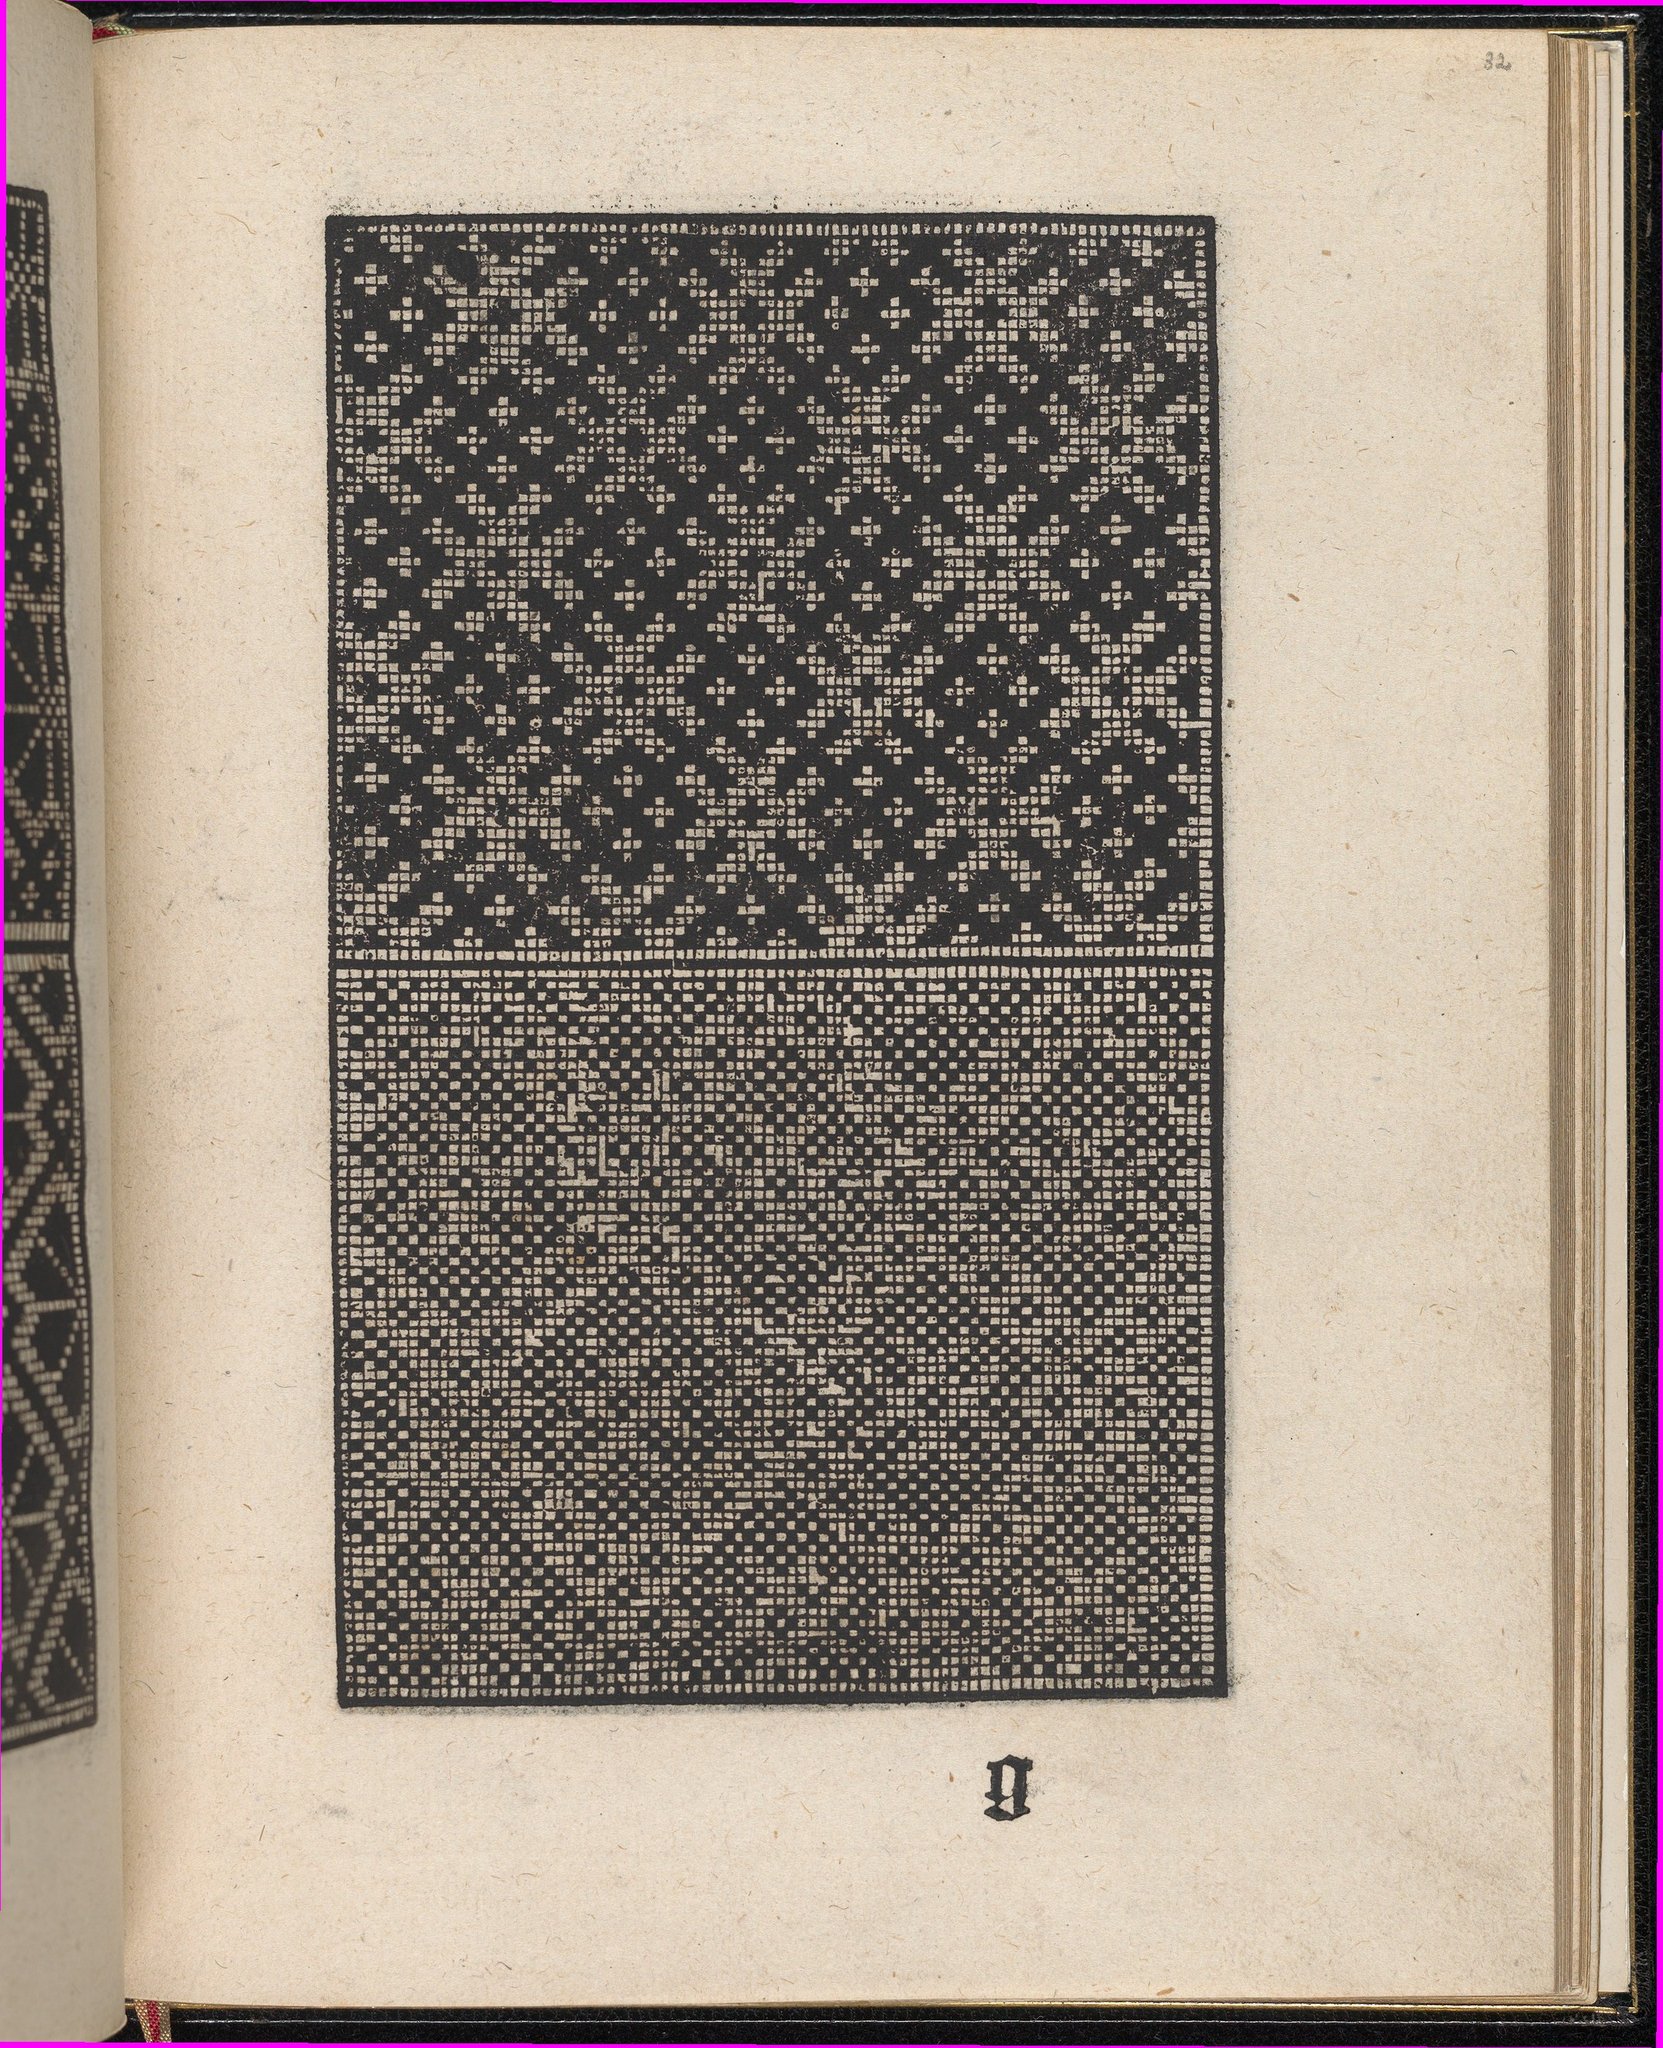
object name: book print ornament architecture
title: Page from Ein new kunstlich Modelbuch...(Page 32r)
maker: peter quentel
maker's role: publisher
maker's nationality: german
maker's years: 1500-1550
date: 1544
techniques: woodcut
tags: ornament